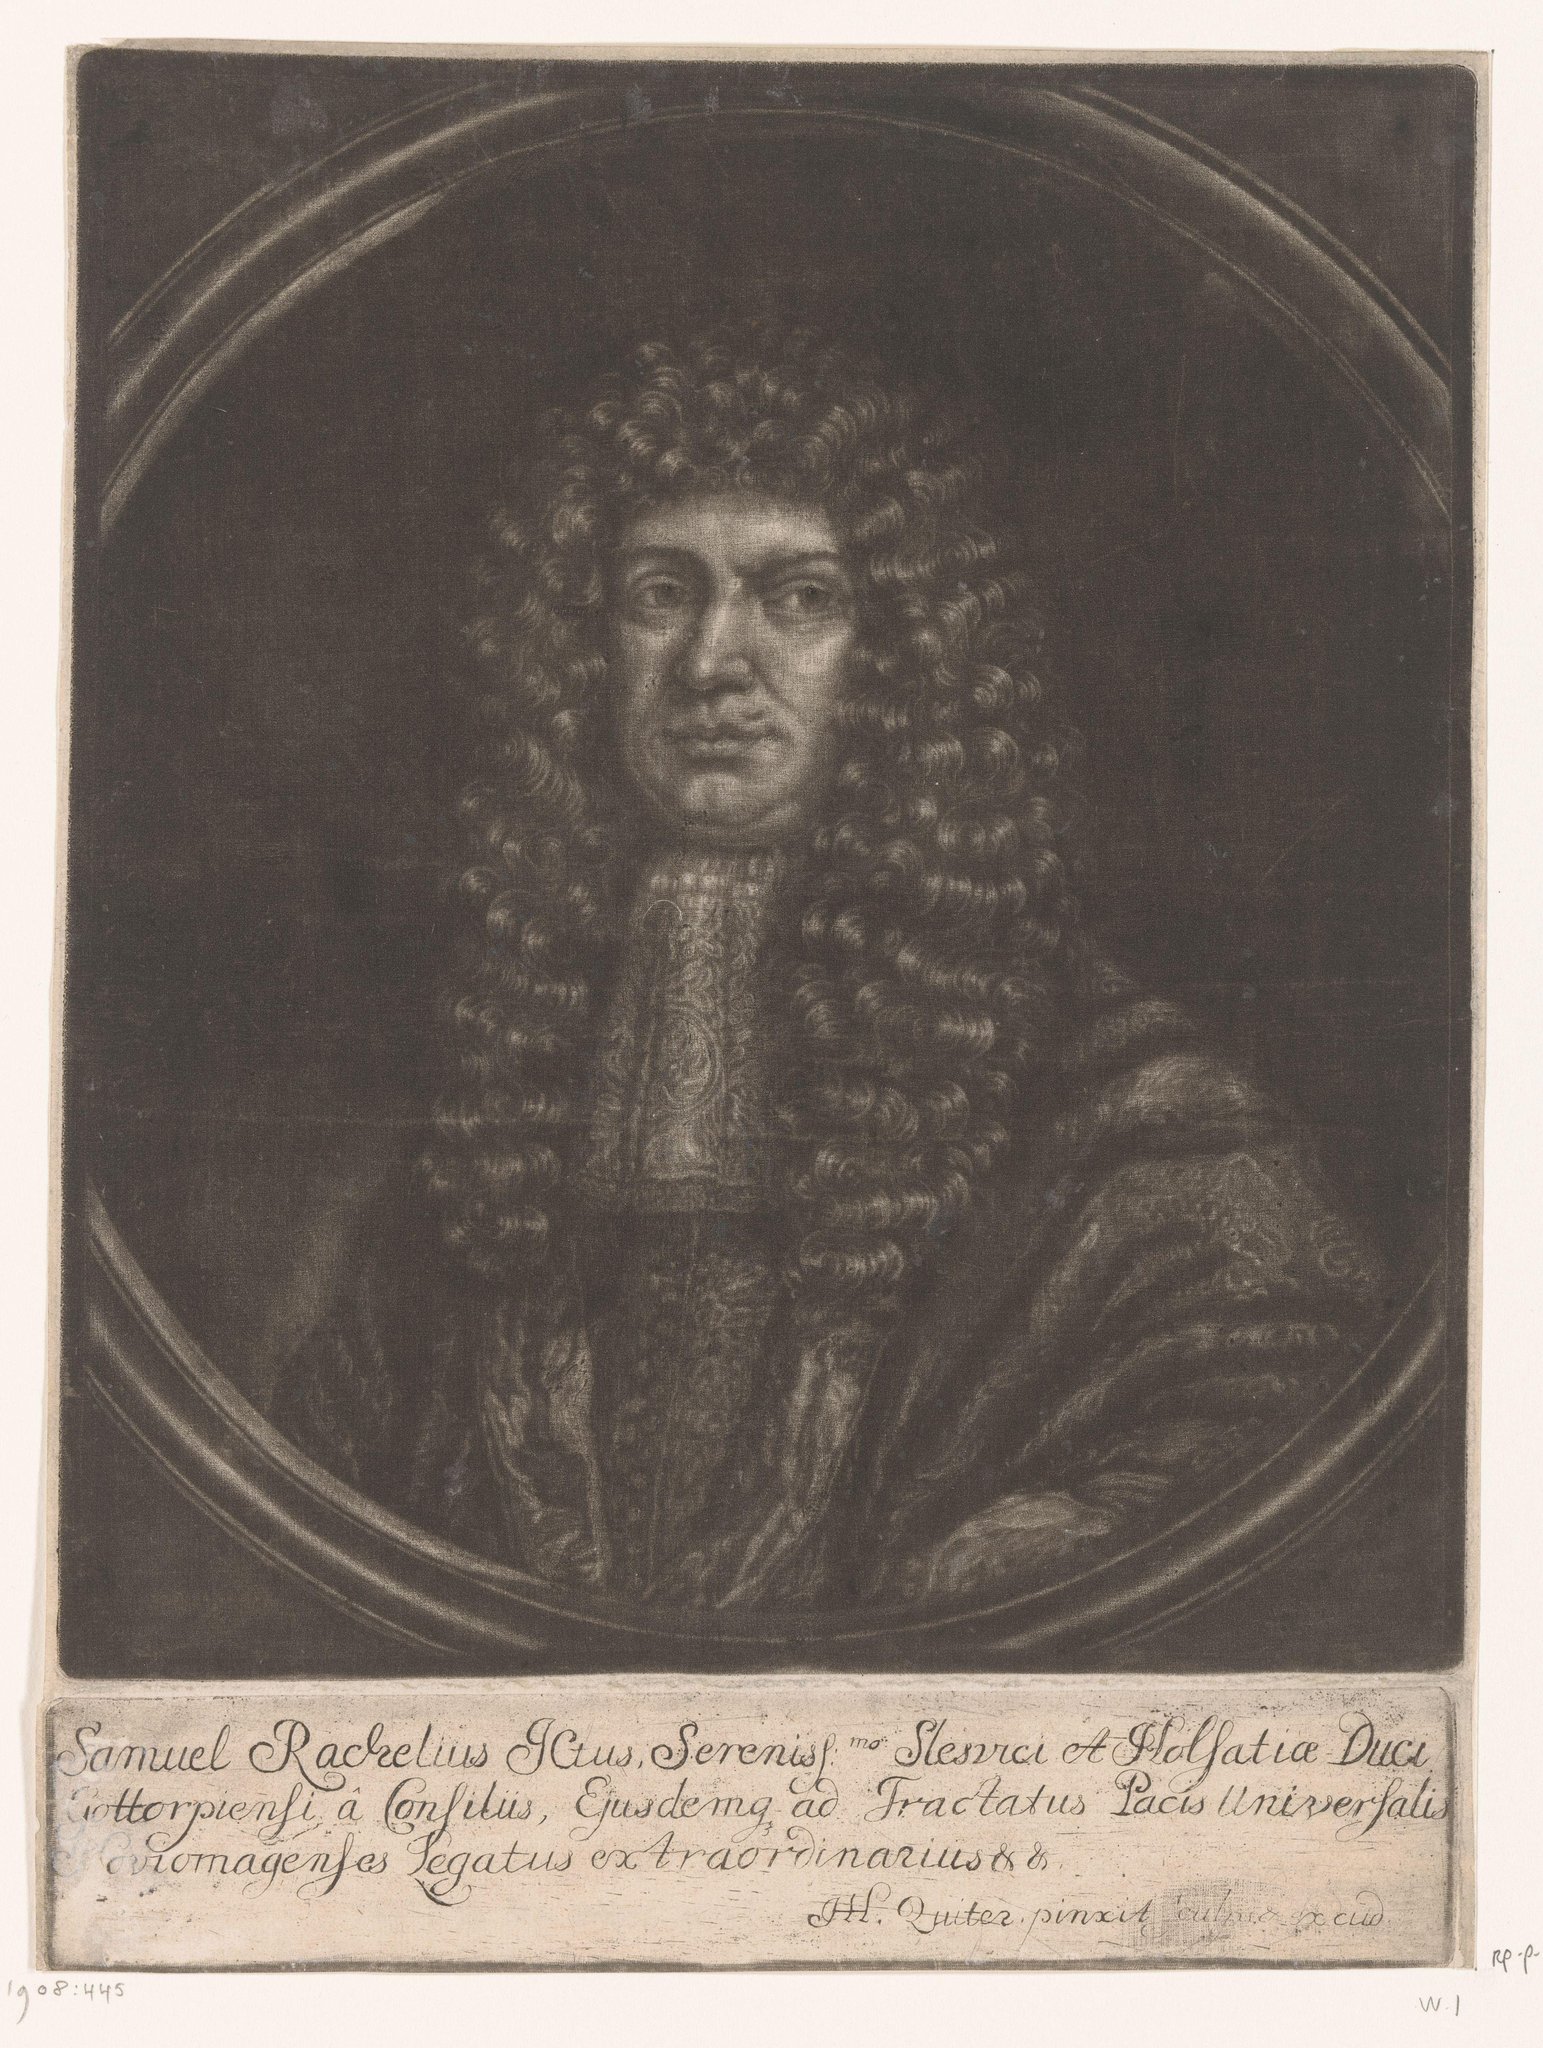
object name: print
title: Portret van Johannes Reuter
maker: herman hendrik de quiter (i)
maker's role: painter, print maker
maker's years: 1627-1708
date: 1679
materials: paper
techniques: mezzotint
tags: historical persons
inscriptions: collector's mark: Lugt 2228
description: Prent voor het eerst gebruikt in: Quiter, Hermann Hendrik. Icones legatorum (...). Nijmegen: s.n., 1679. De tekst is gedrukt van een andere plaat en hoort bij een ander portret.